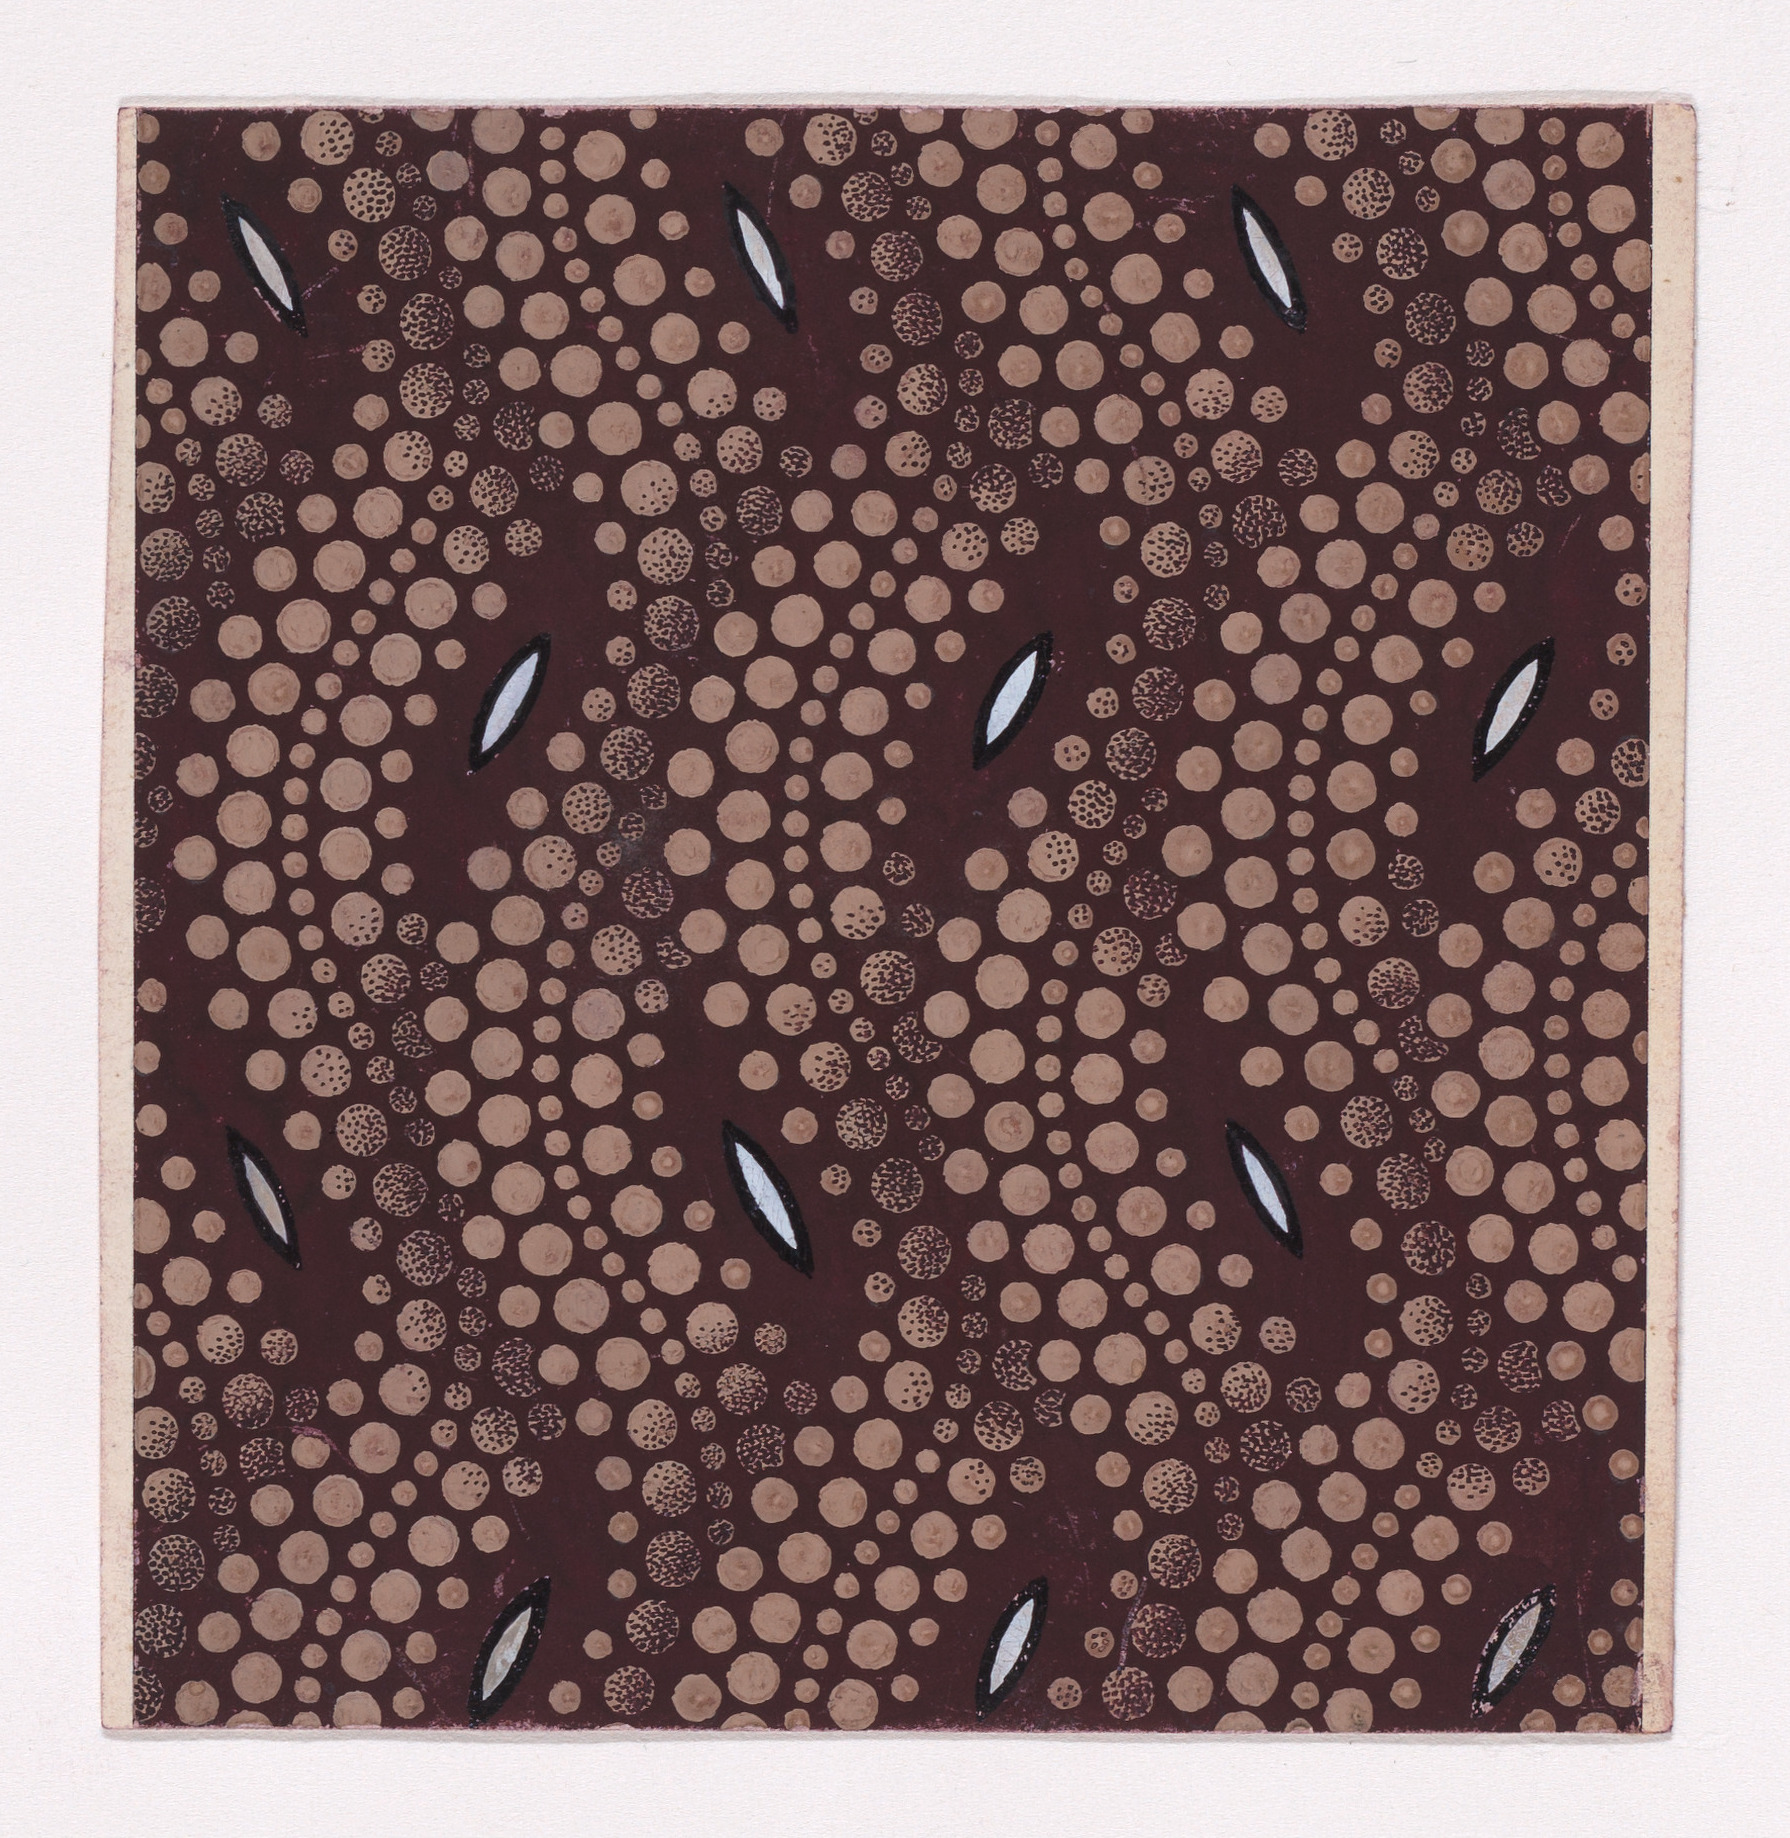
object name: drawing ornament architecture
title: Textile Design with Overlapping Groups of Five Undulating Vertical Stripes of Pearls and Shuttle-Shaped Motifs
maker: anonymous, alsatian, 19th century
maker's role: artist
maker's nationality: alsatian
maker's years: 1800-1900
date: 1840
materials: gouache